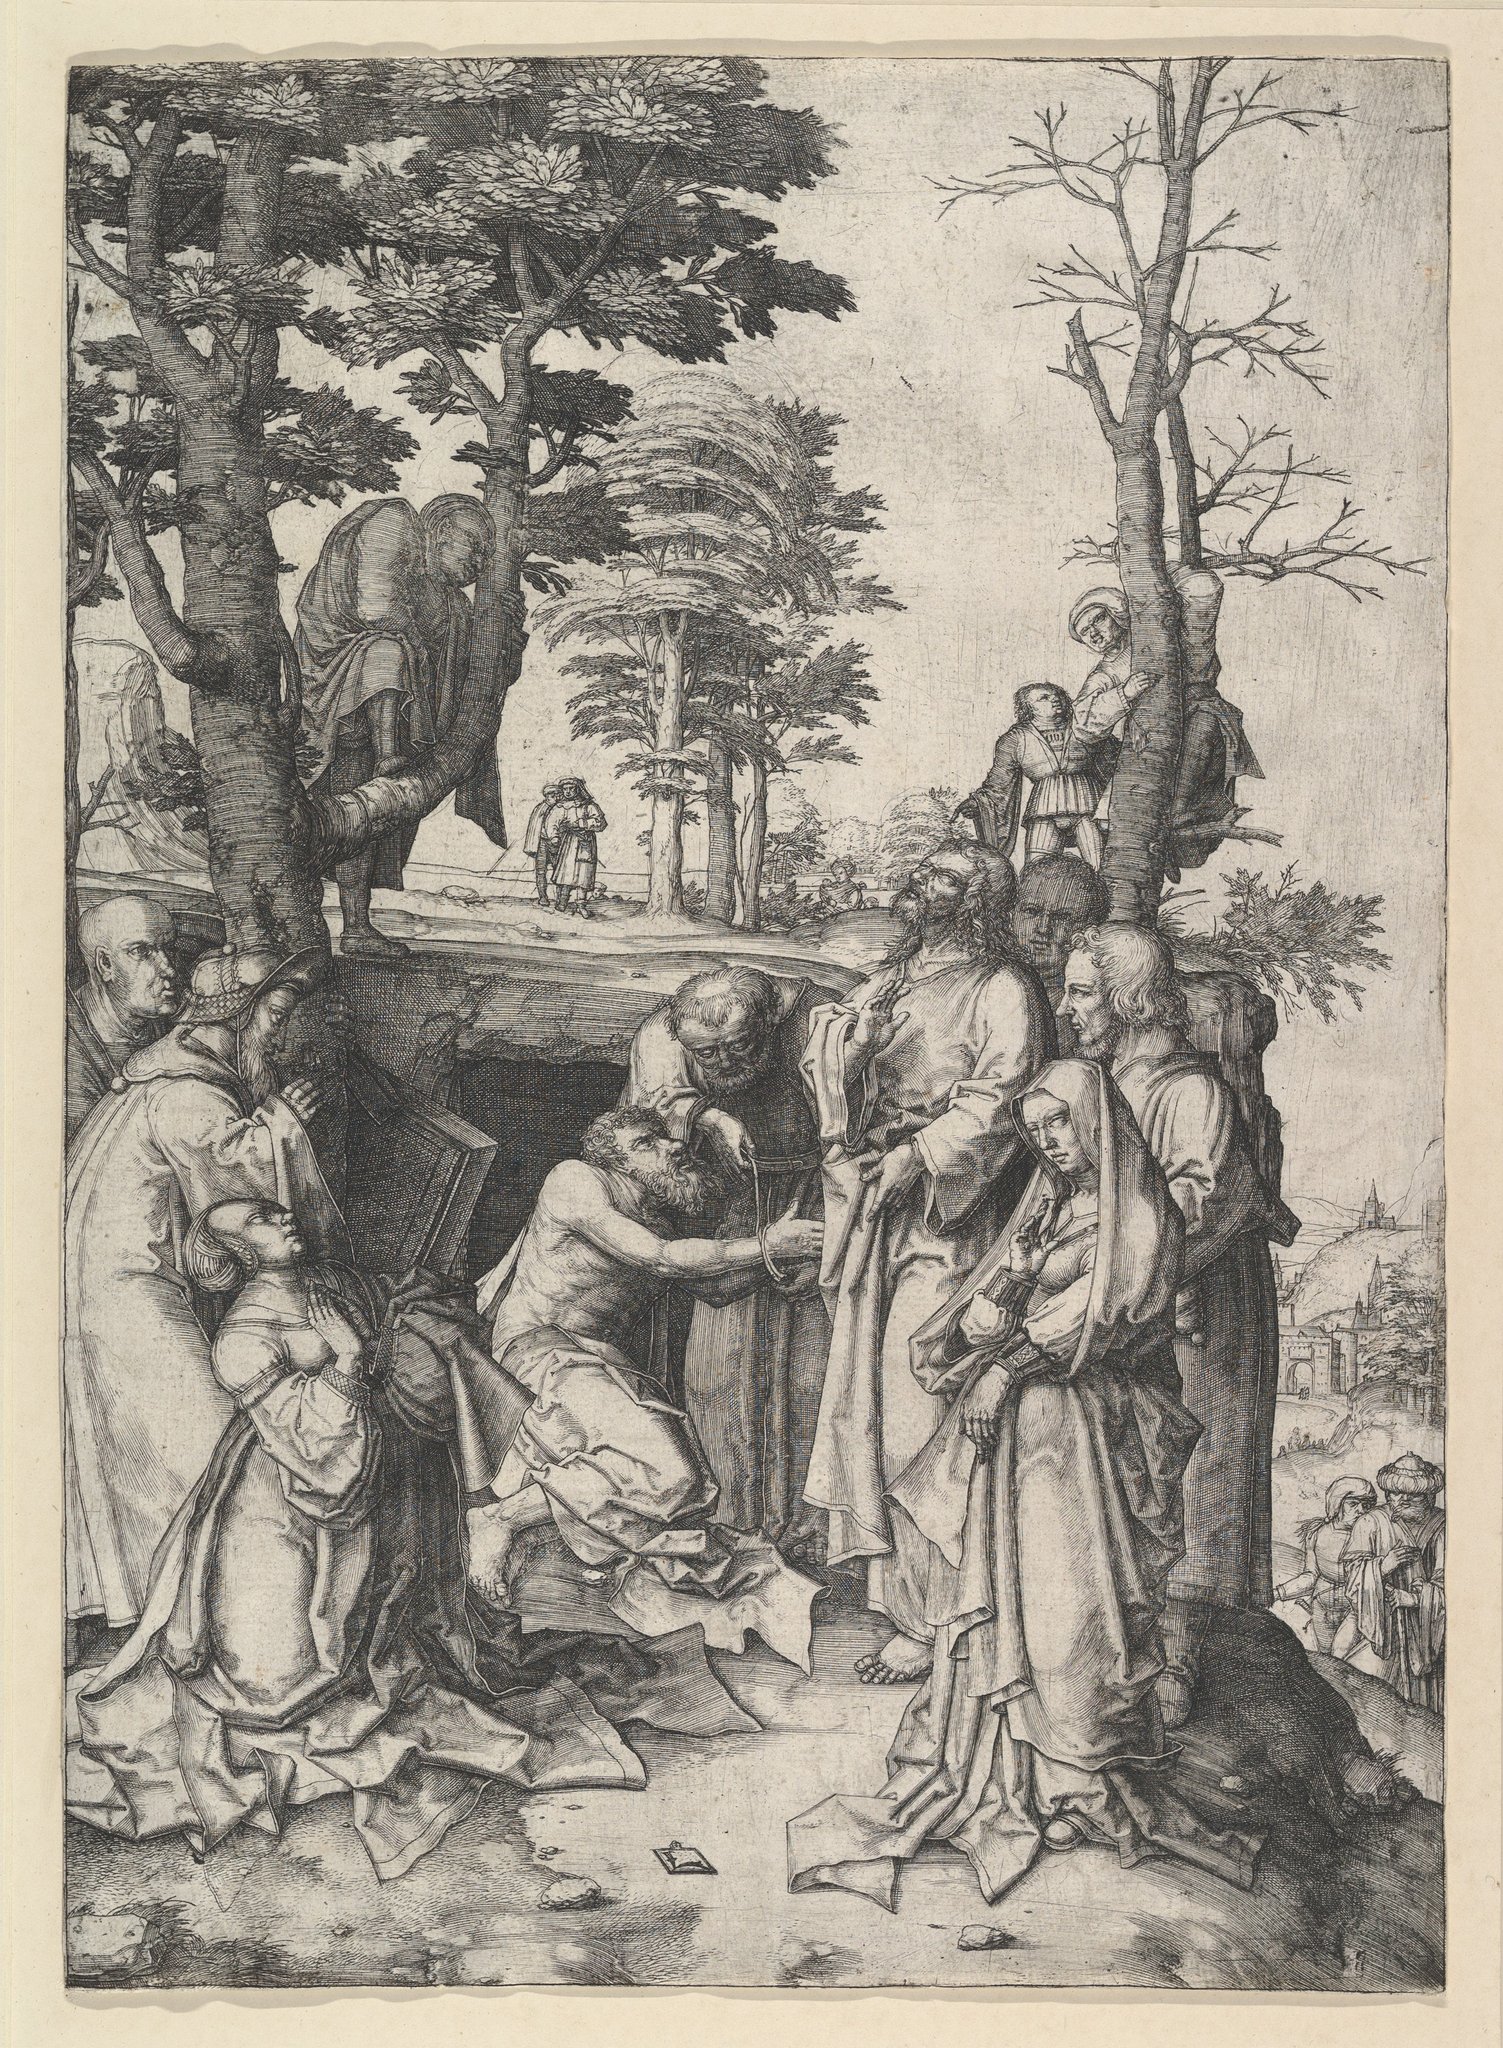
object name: print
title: The Raising of Lazarus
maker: lucas van leyden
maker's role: artist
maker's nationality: netherlandish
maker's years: 1494-1533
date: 1507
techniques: engraving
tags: men,women,christ